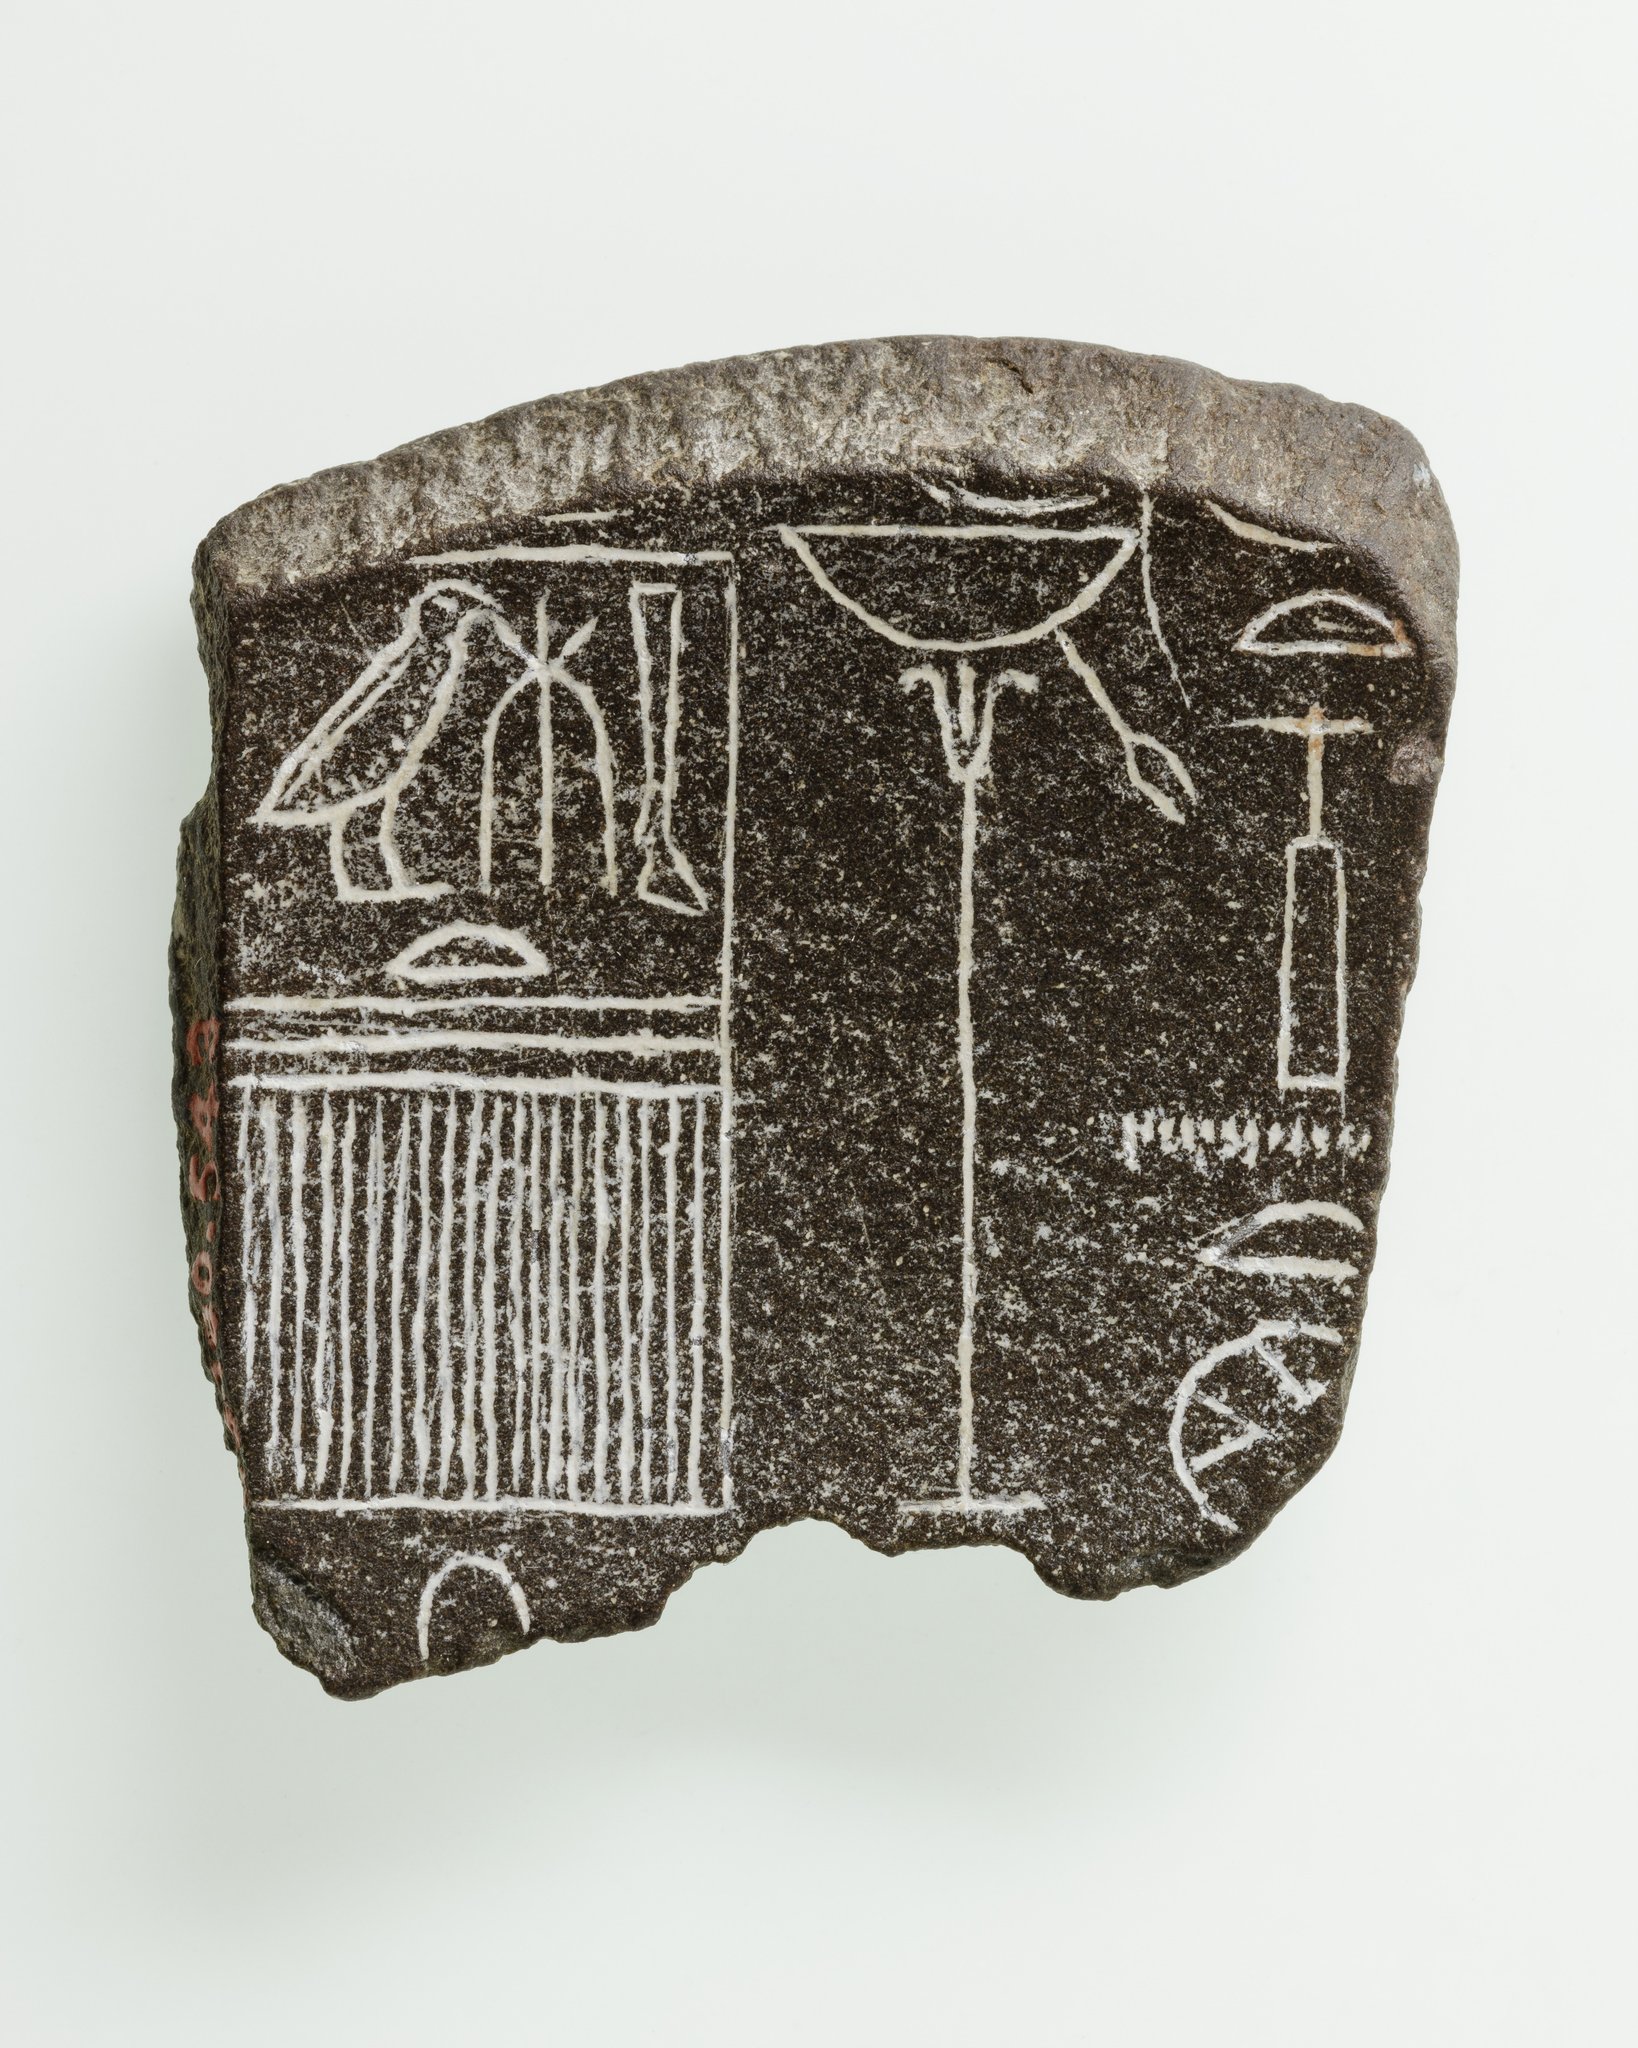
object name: dish fragment, hathor of dendera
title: Fragment of a Dish Dedicated by Two Kings to the Goddess Hathor of Dendera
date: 1988-1952 BCE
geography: egypt